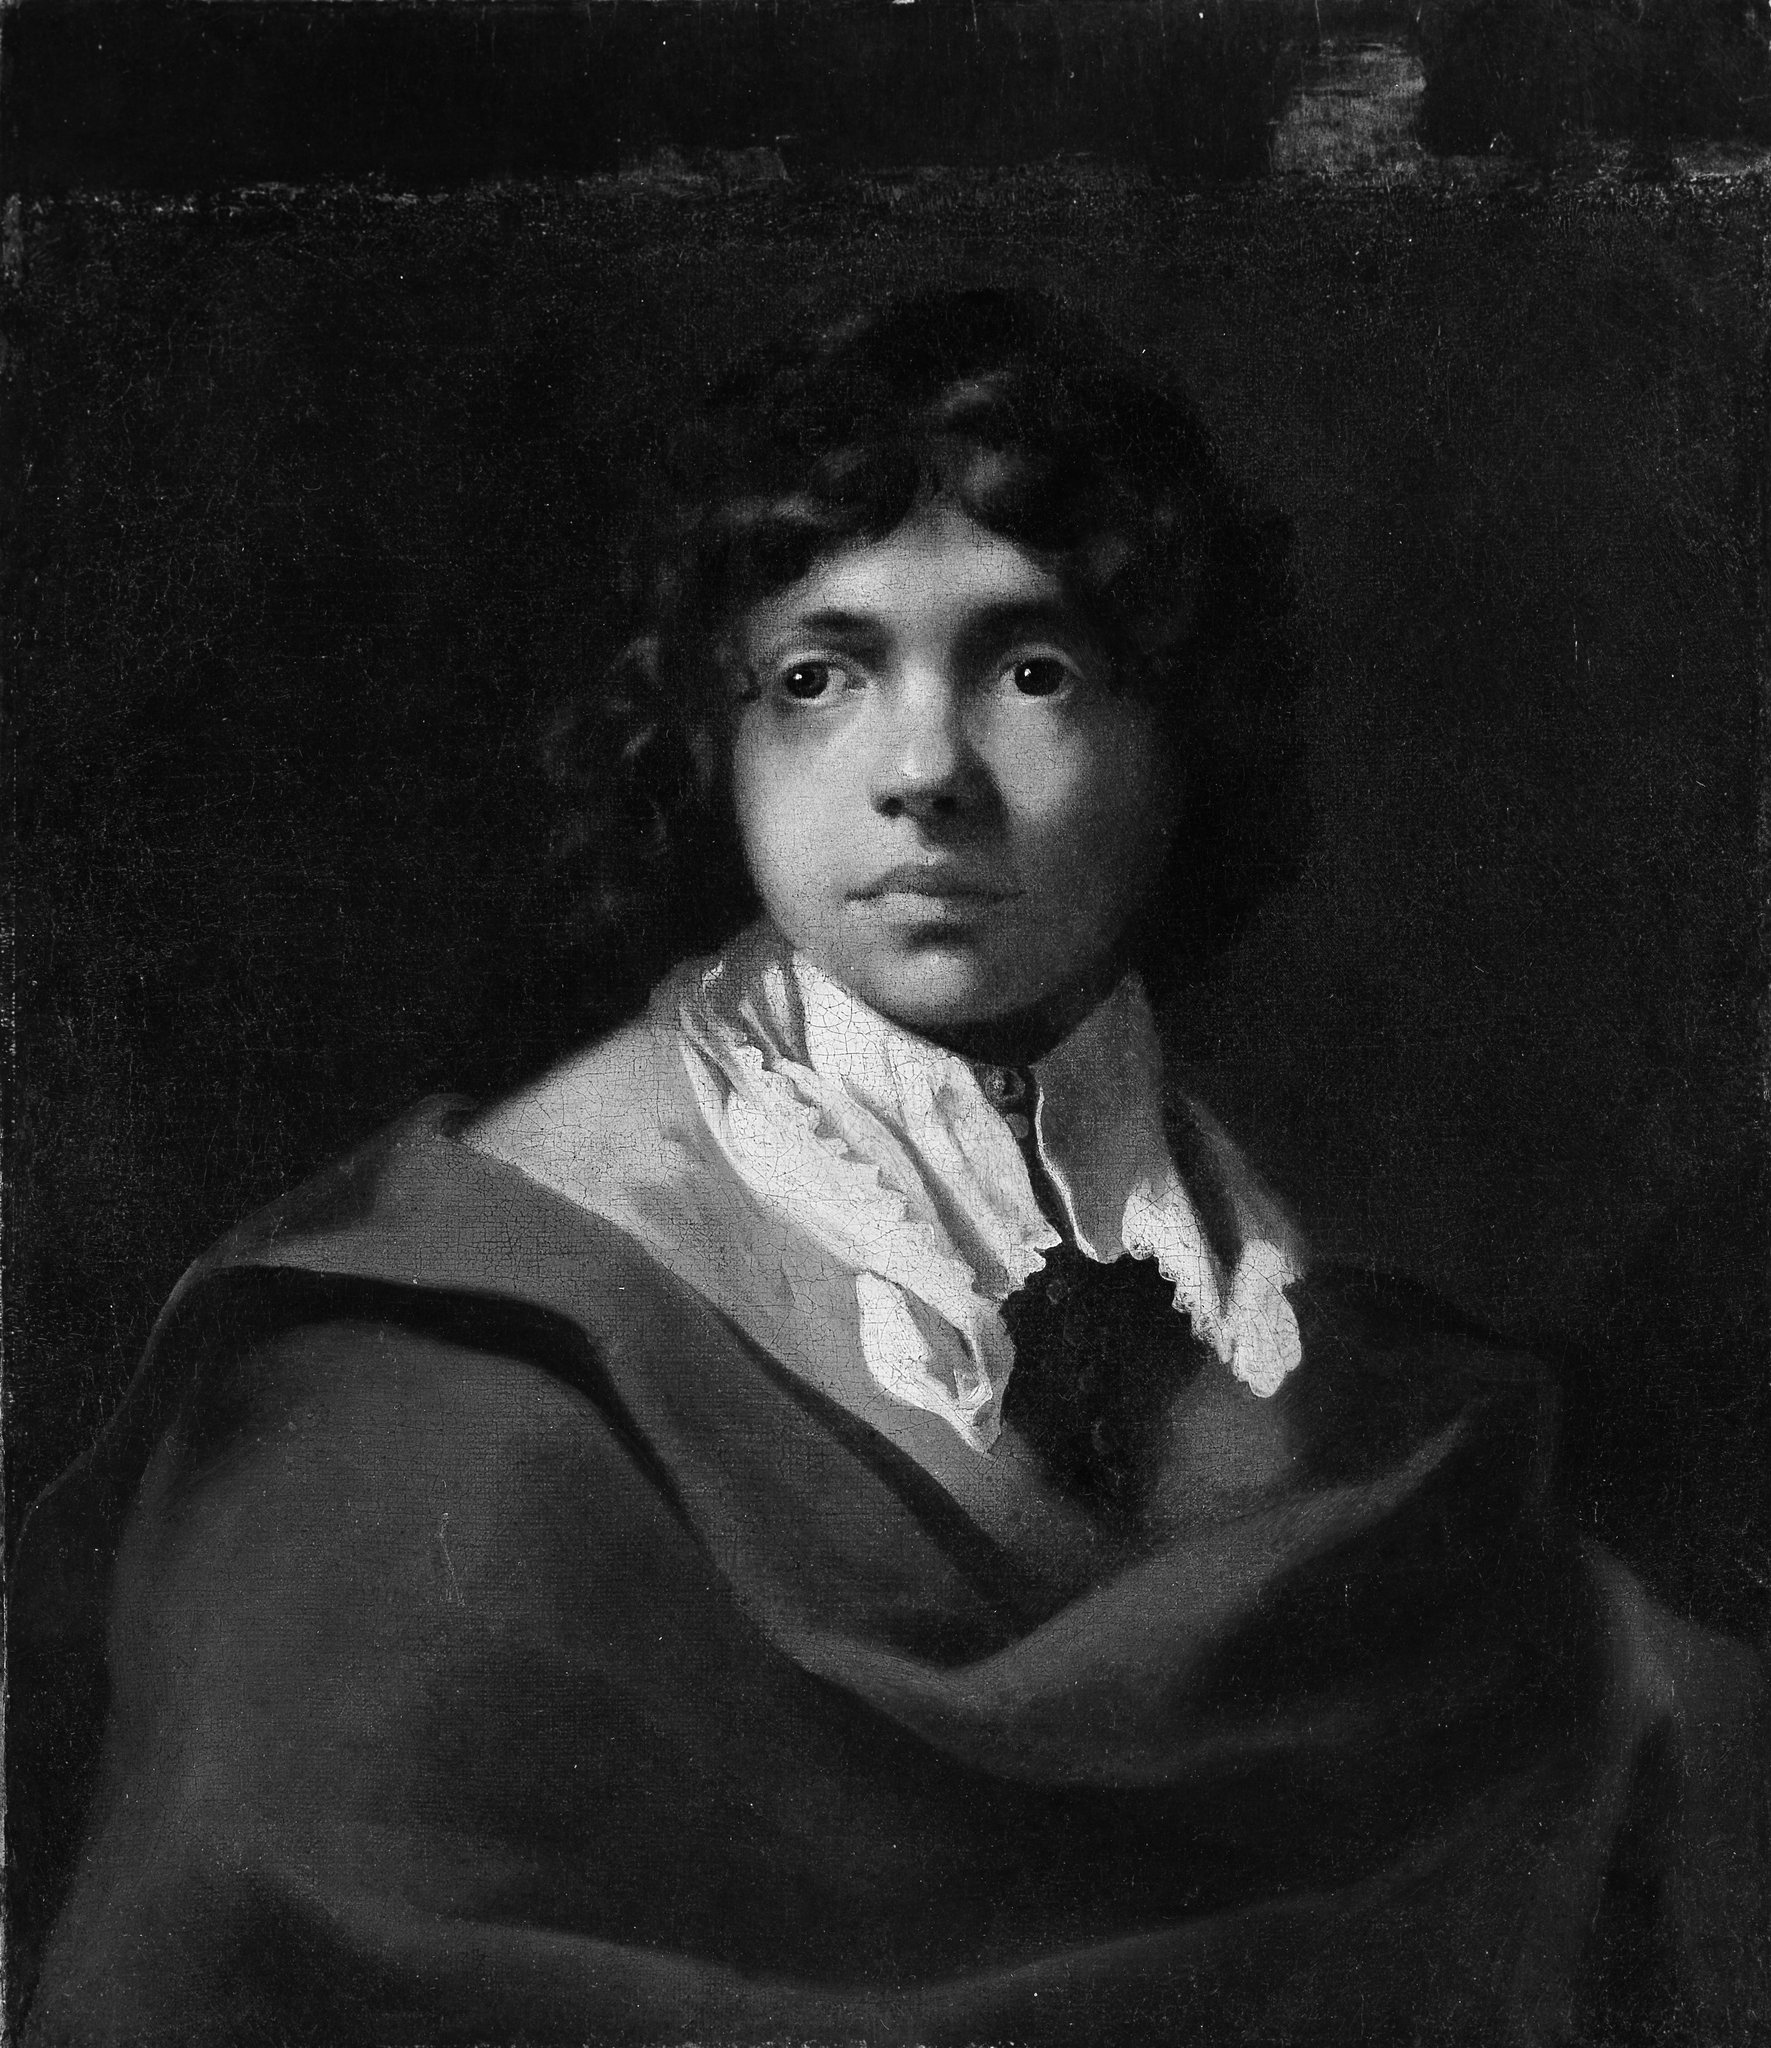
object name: painting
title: Portrait of a Young Boy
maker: sébastien bourdon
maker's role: artist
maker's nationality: french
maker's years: 1616-1671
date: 1636-1671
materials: canvas, oil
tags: boys,portraits